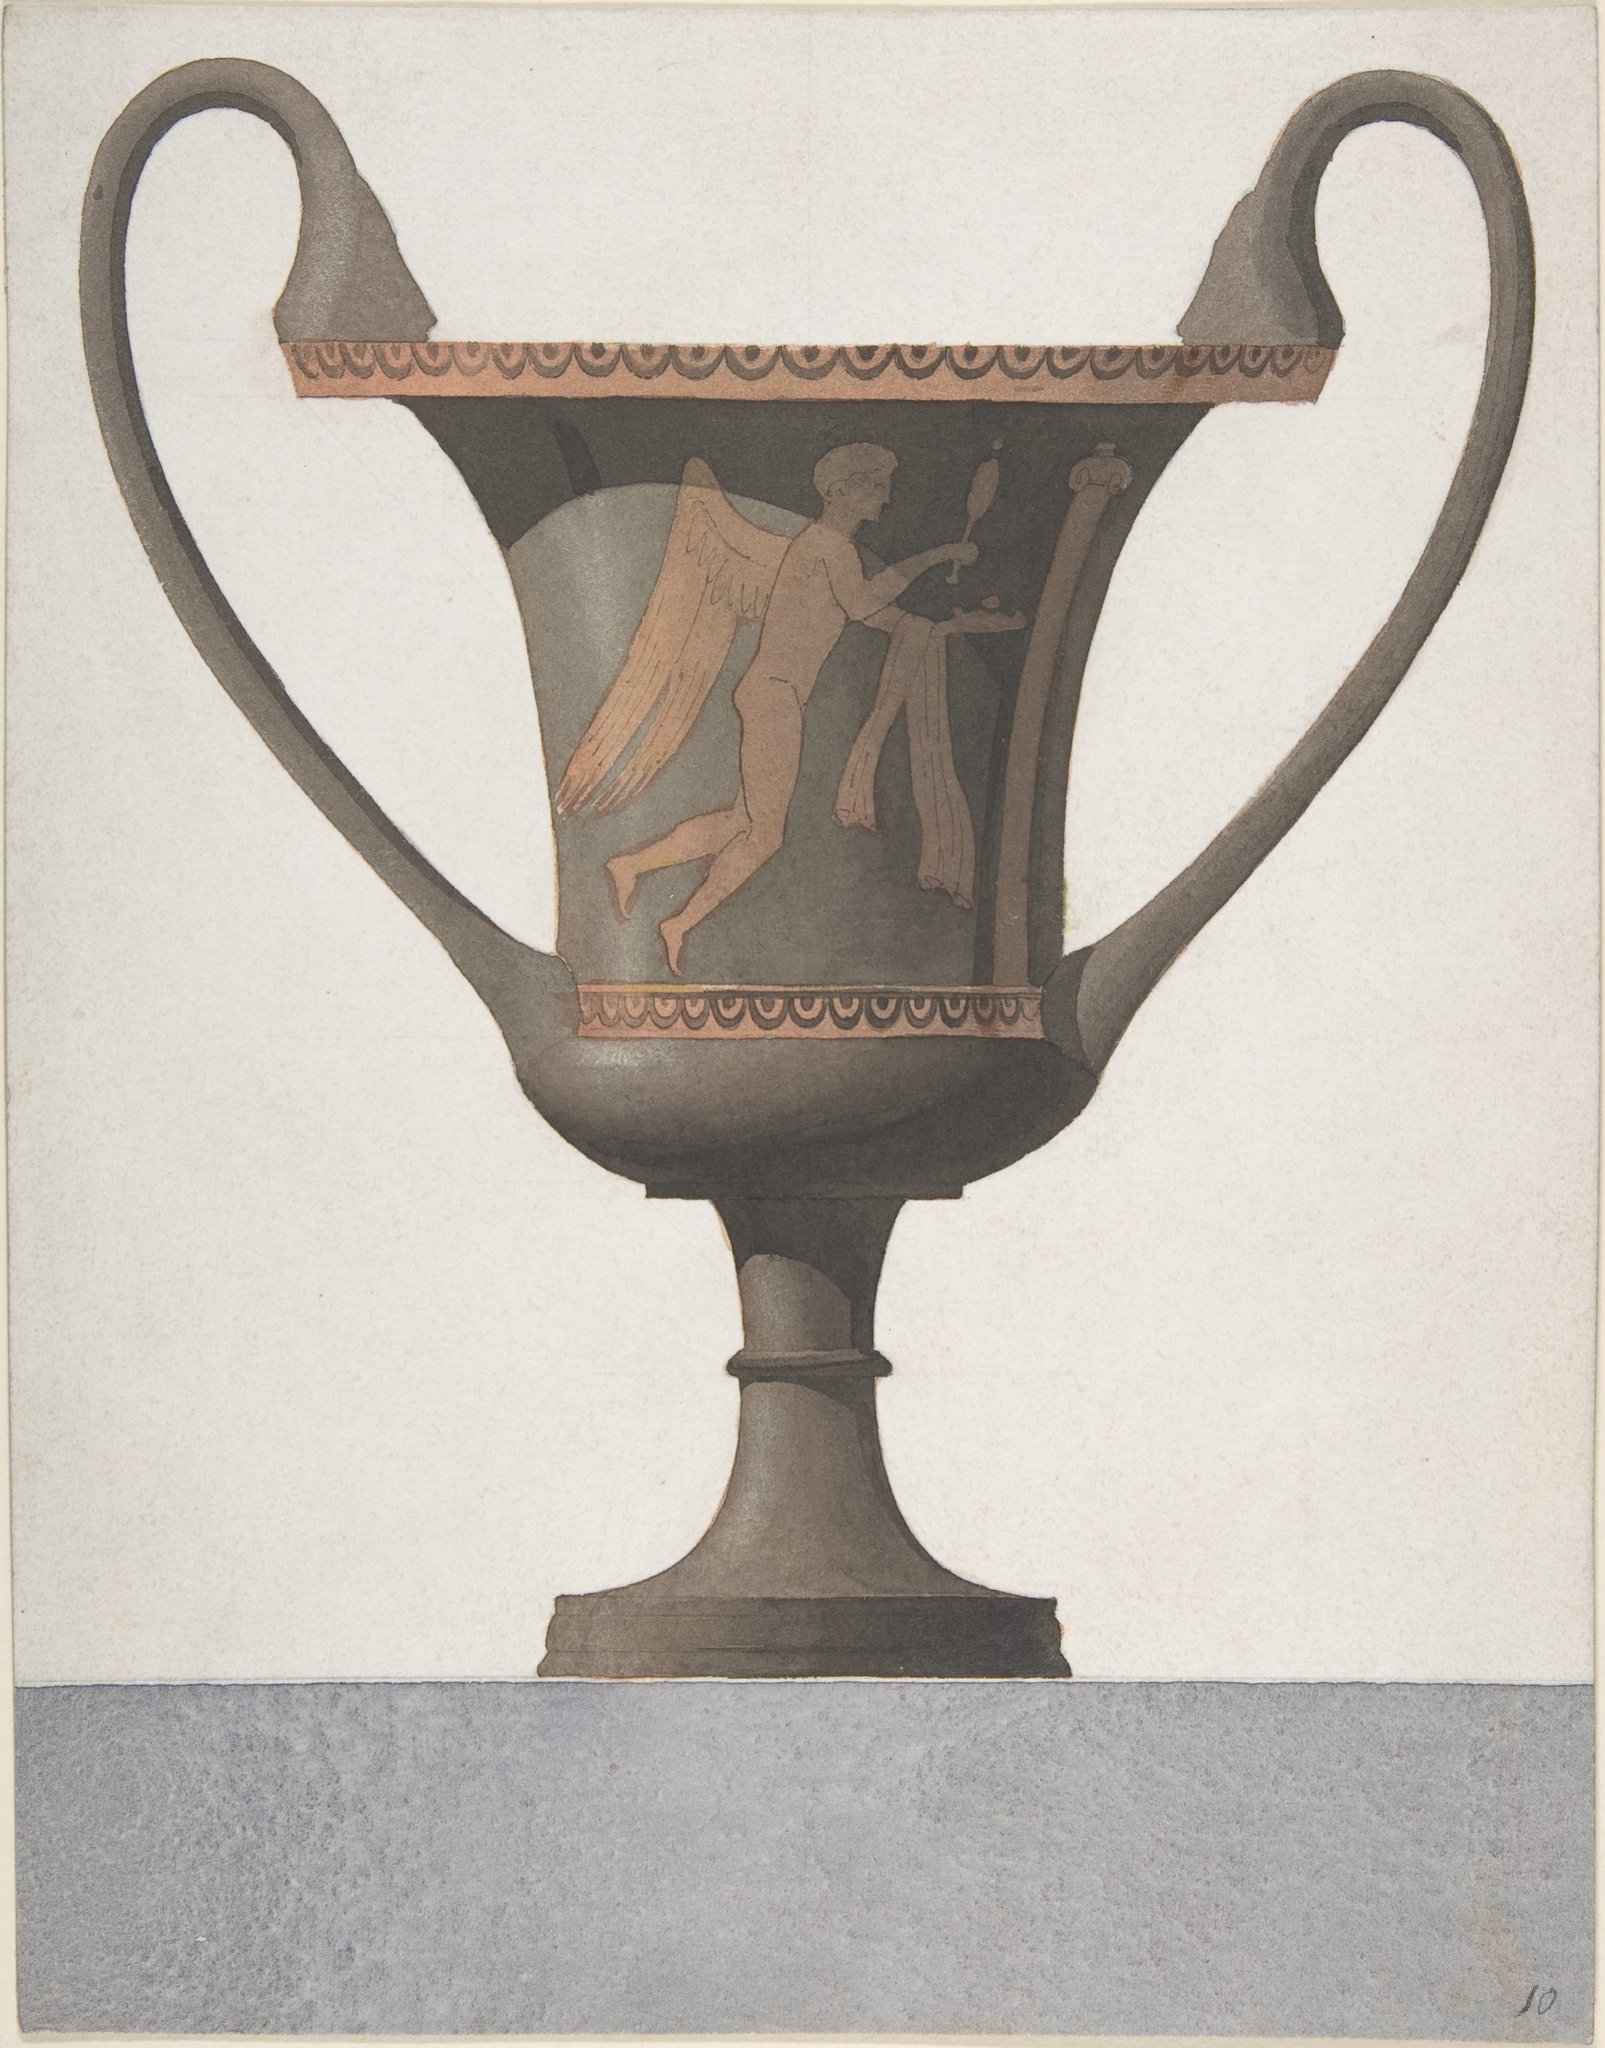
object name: drawing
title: Greek Vase featuring Eros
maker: anonymous, french, 18th century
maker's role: artist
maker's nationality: french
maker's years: 1700-1800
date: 1701-1800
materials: watercolor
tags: eros,vases